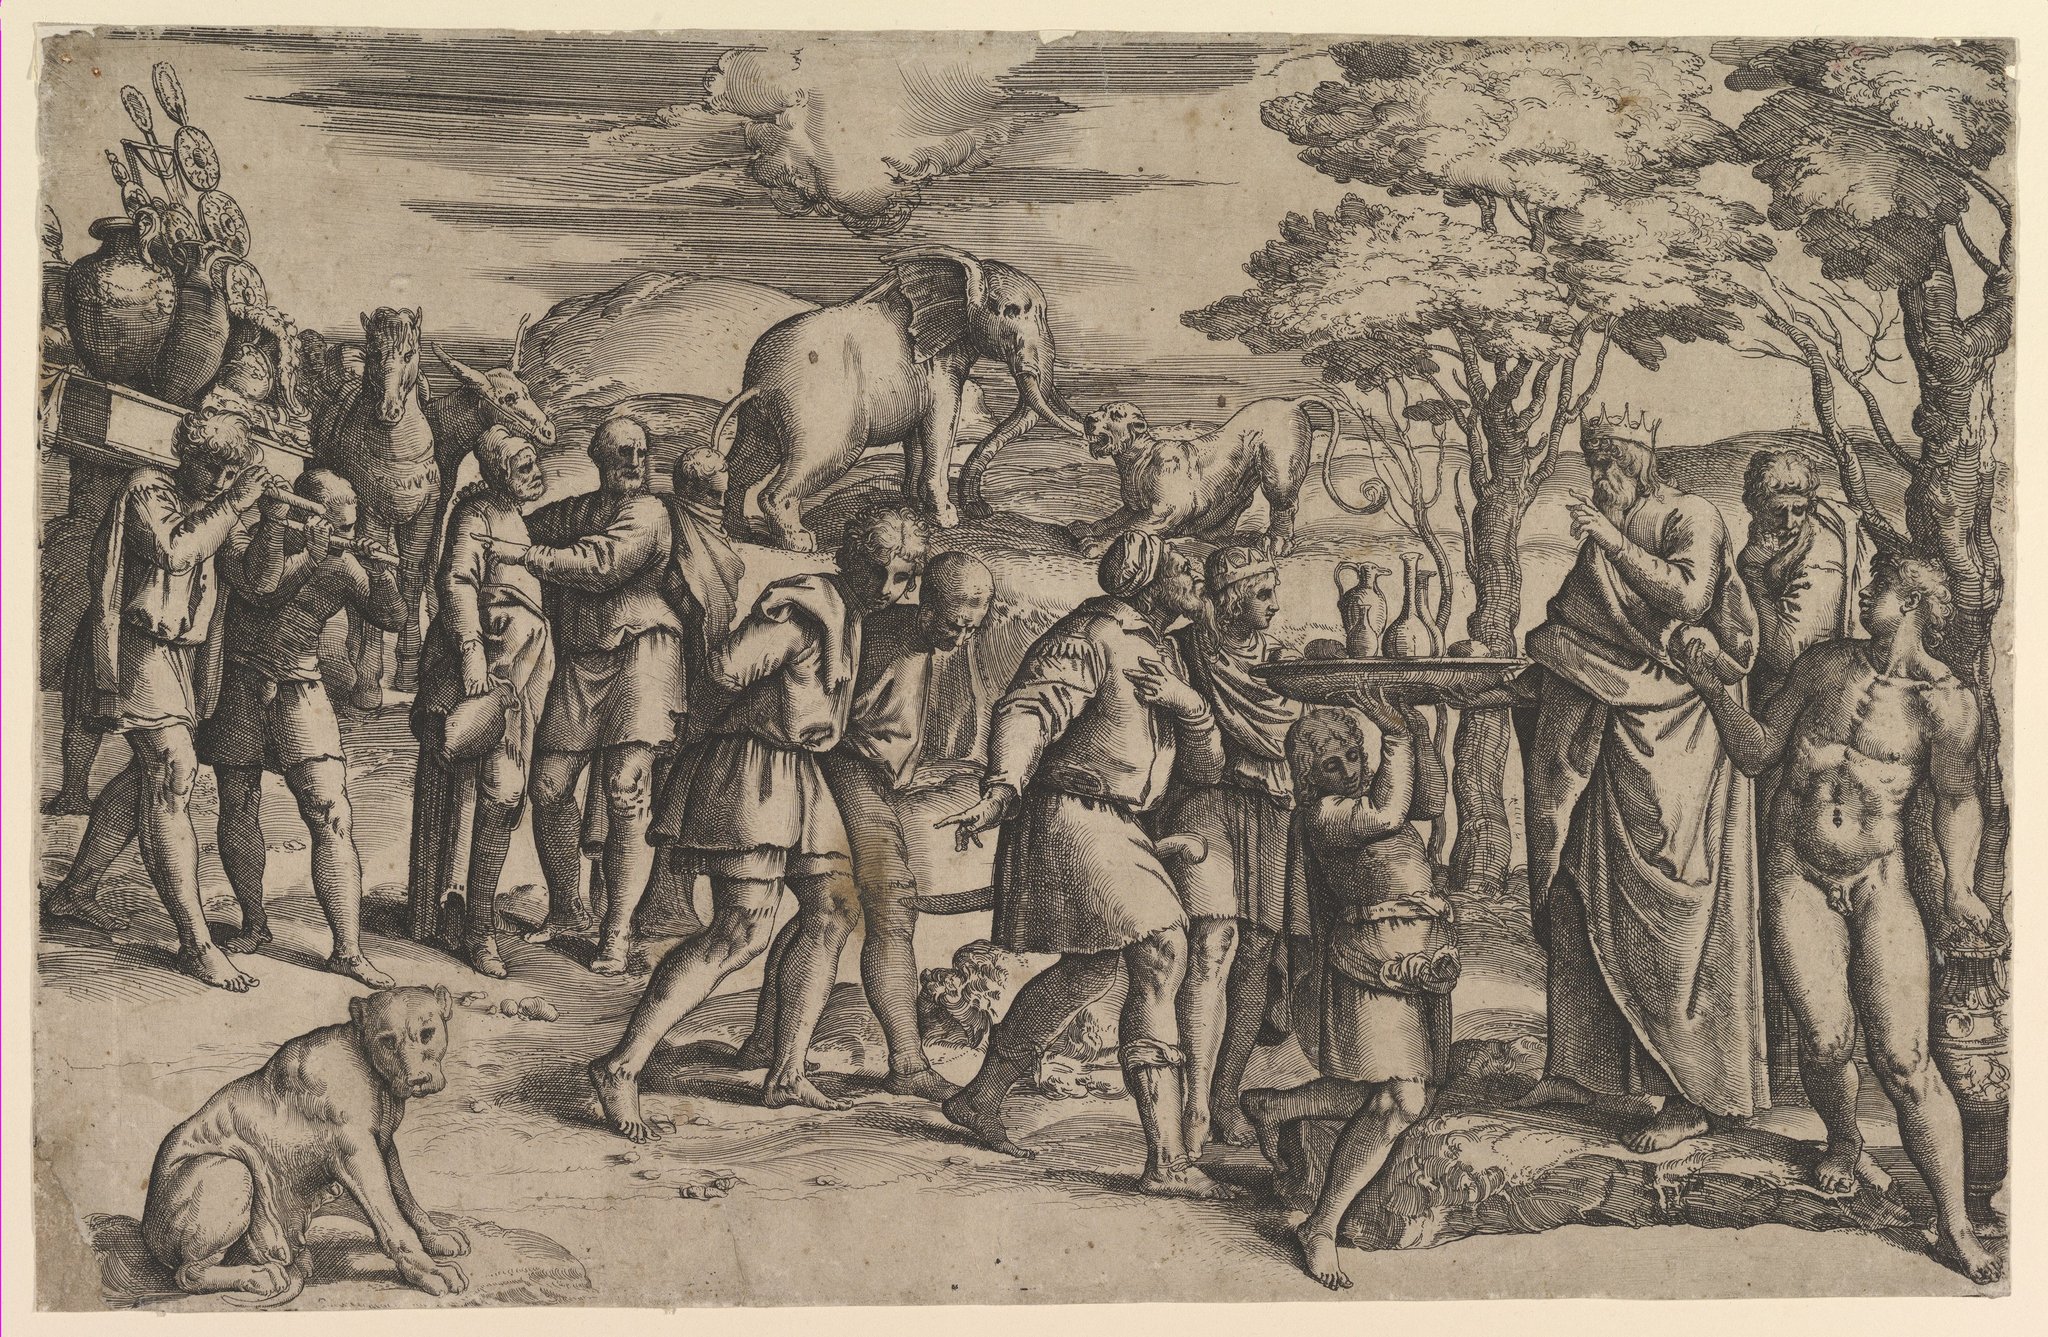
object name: print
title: Melchizadek offering bread and wine to Abraham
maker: battista franco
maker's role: artist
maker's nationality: italian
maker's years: 1510-1561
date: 1545-1561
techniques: engraving, etching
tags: animals,bread,wine,men,dogs,abraham